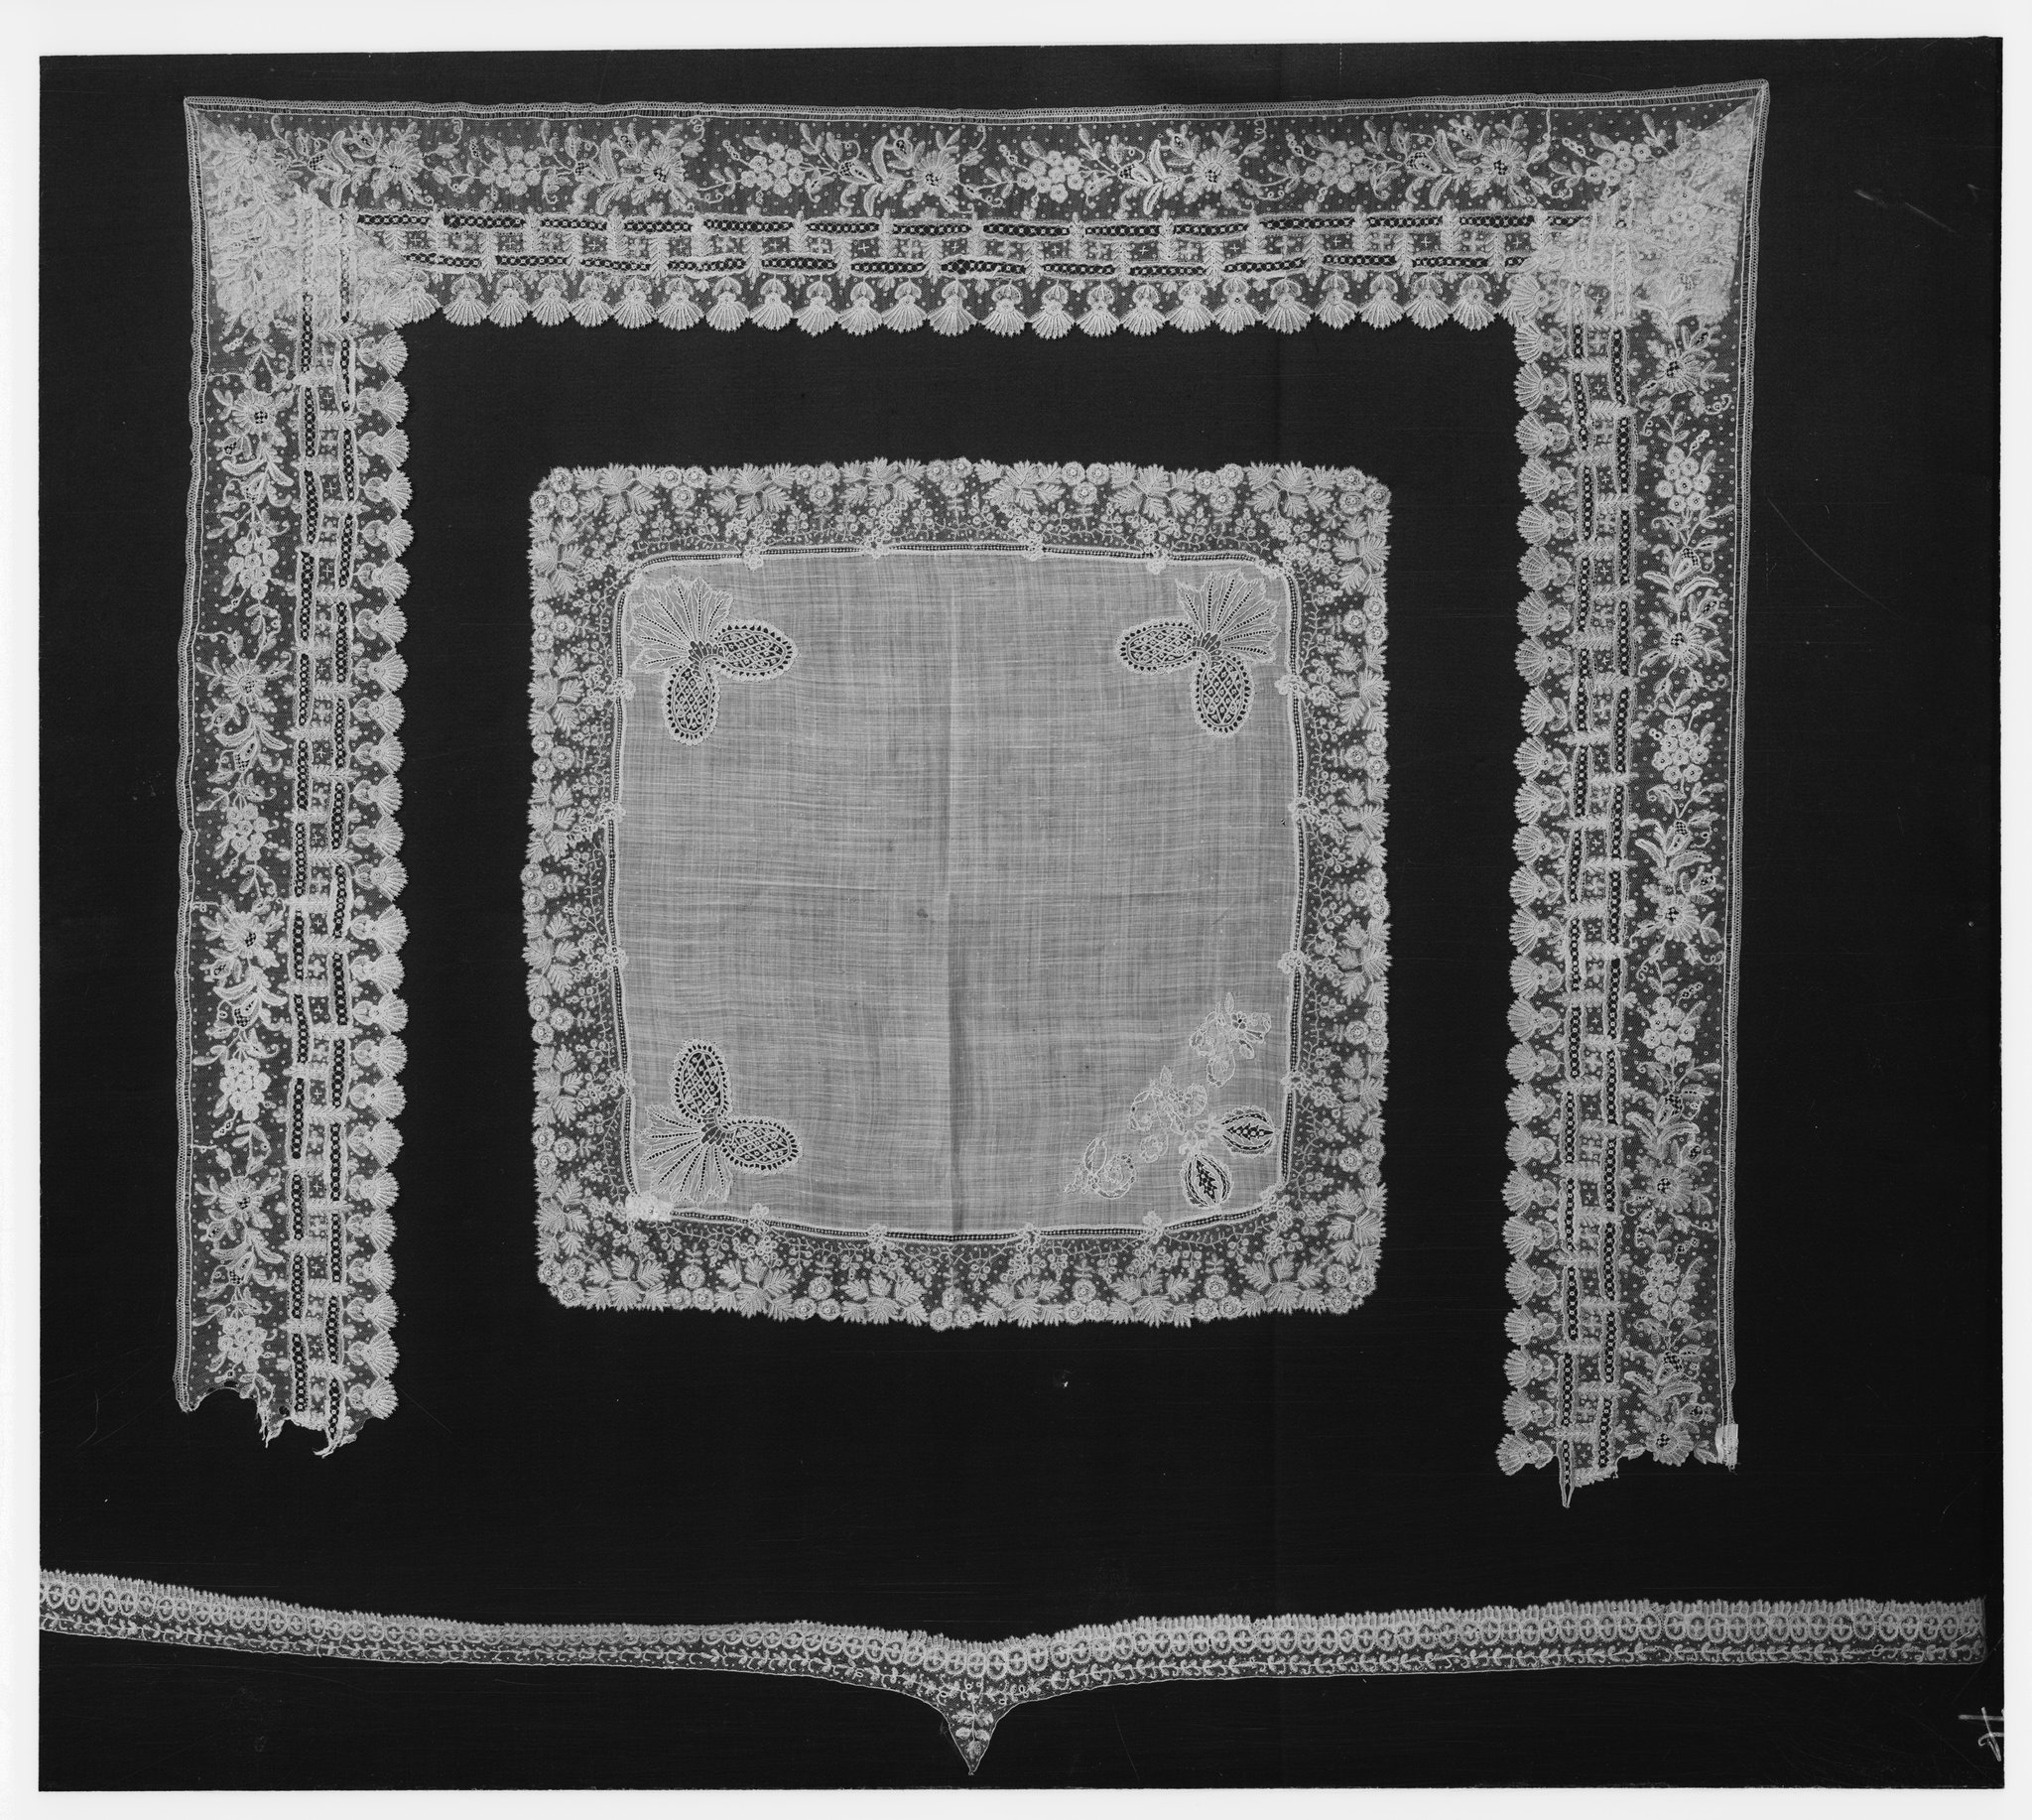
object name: fragment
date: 1801-1900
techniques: lace